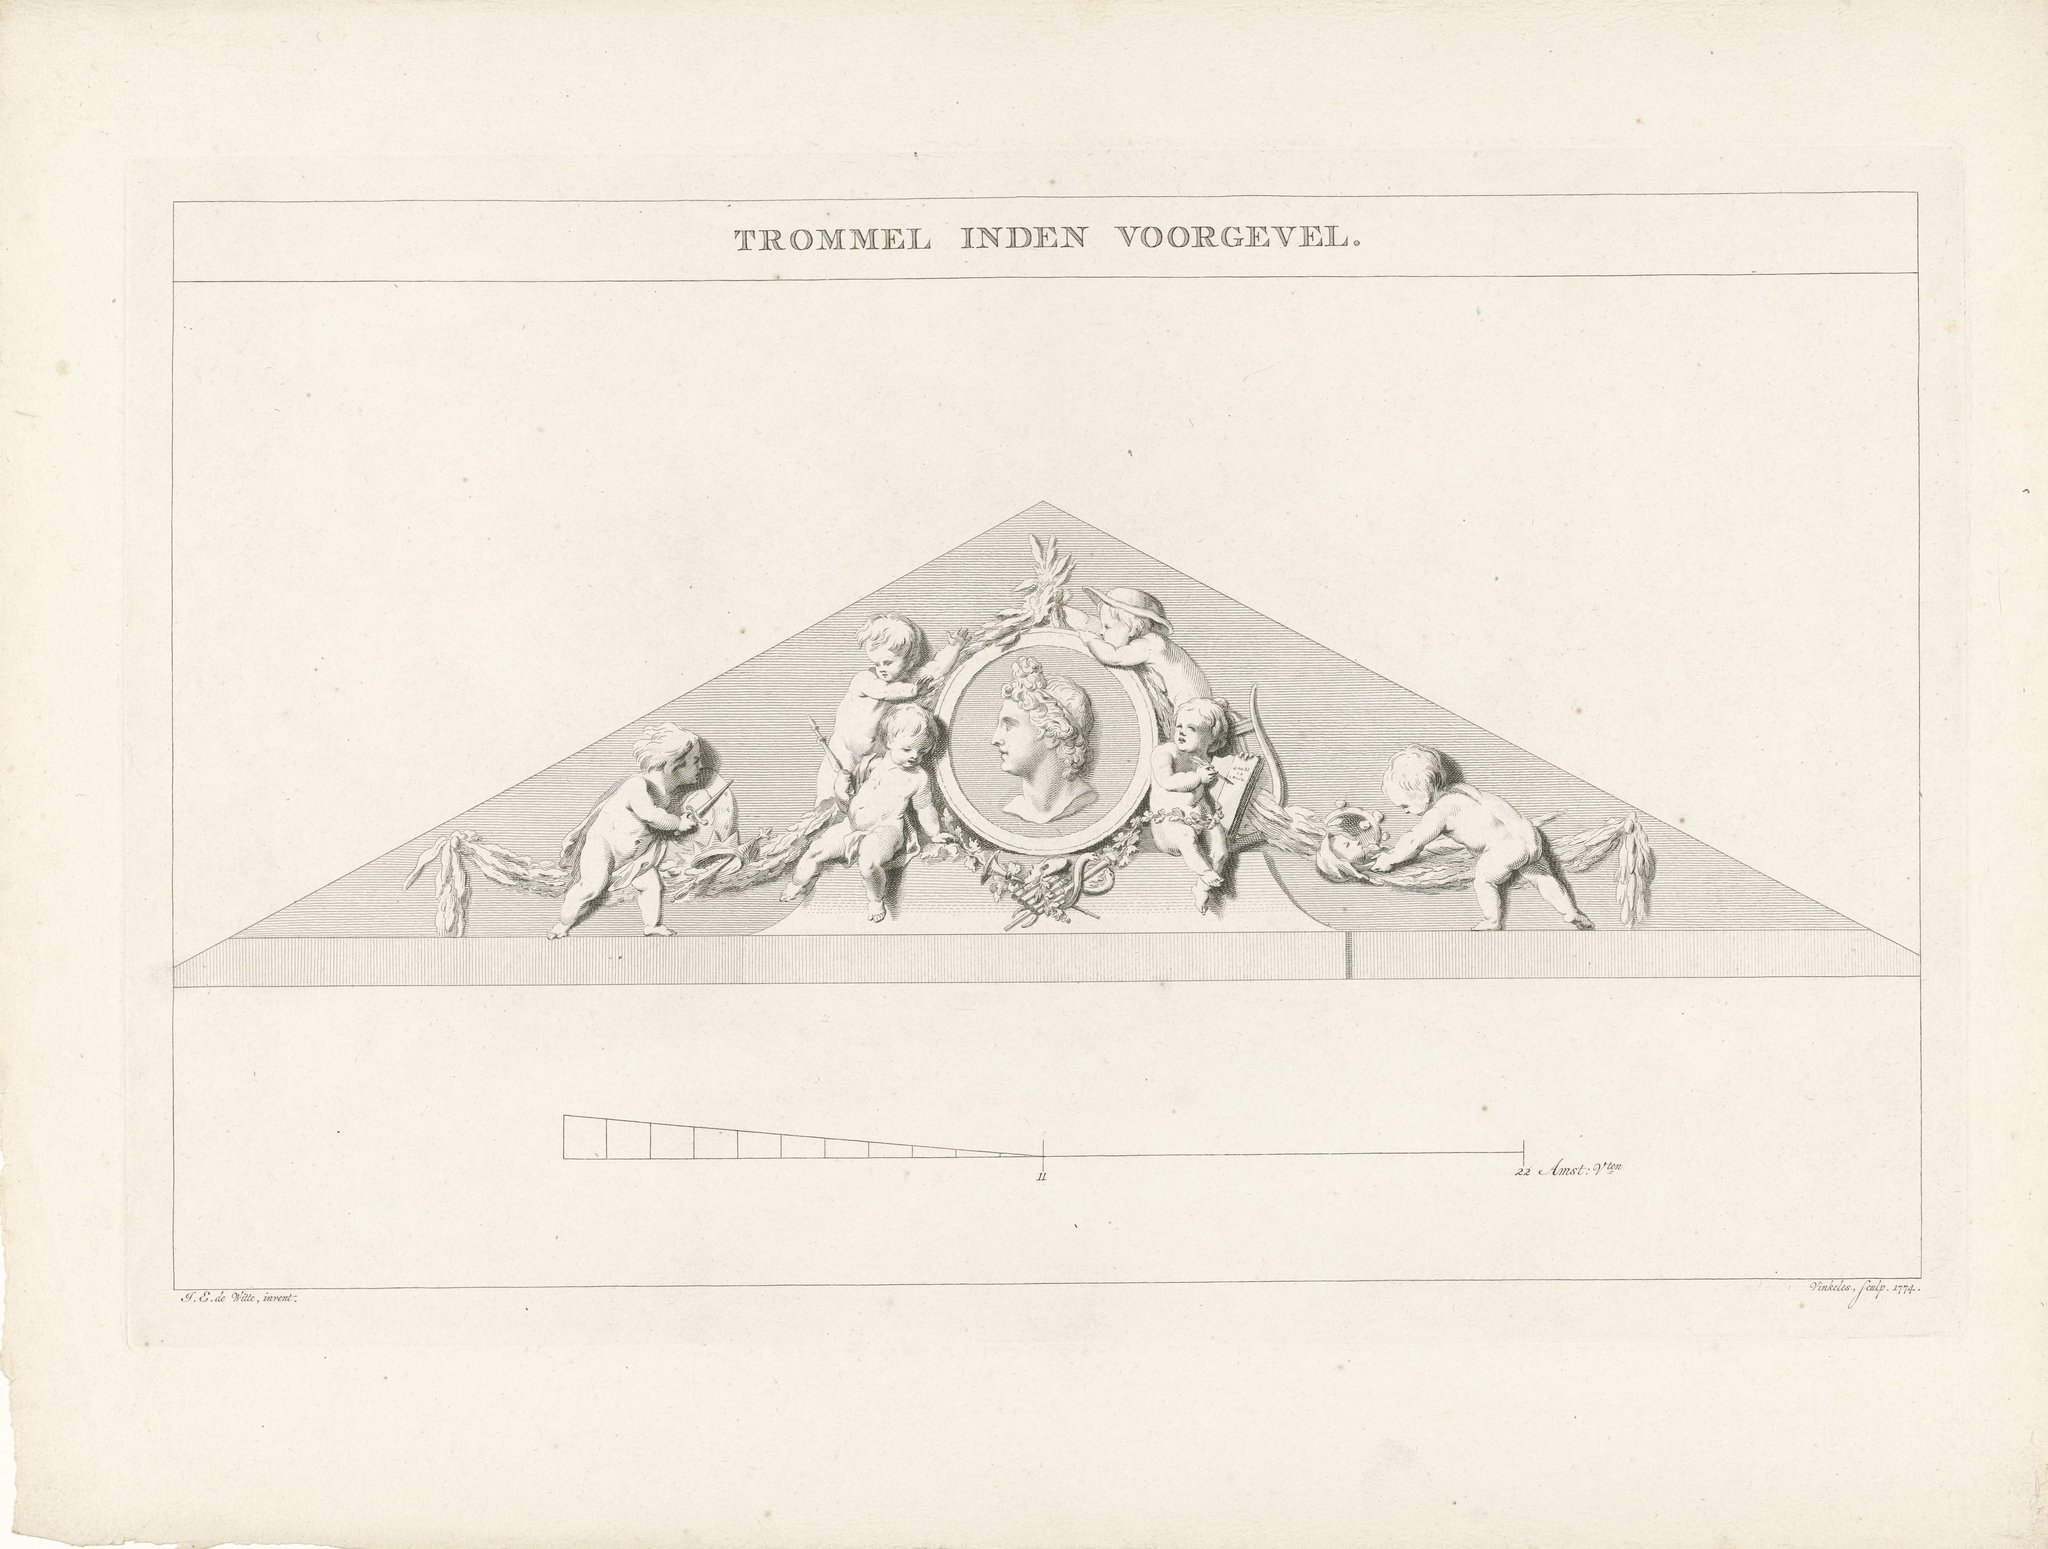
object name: print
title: Trommel inden voorgevel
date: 1774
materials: paper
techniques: etching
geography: amsterdam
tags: print maker, jacob eduard de witte, theatre (building), architectural design or model, surface decorations ~ architecture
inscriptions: collector's mark: Lugt 2228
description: Het fronton in de voorgevel, medaillon met spelende putti. Onderdeel van een reeks van veertien platen van de nieuwe Schouwburg te Amsterdam, 1774.